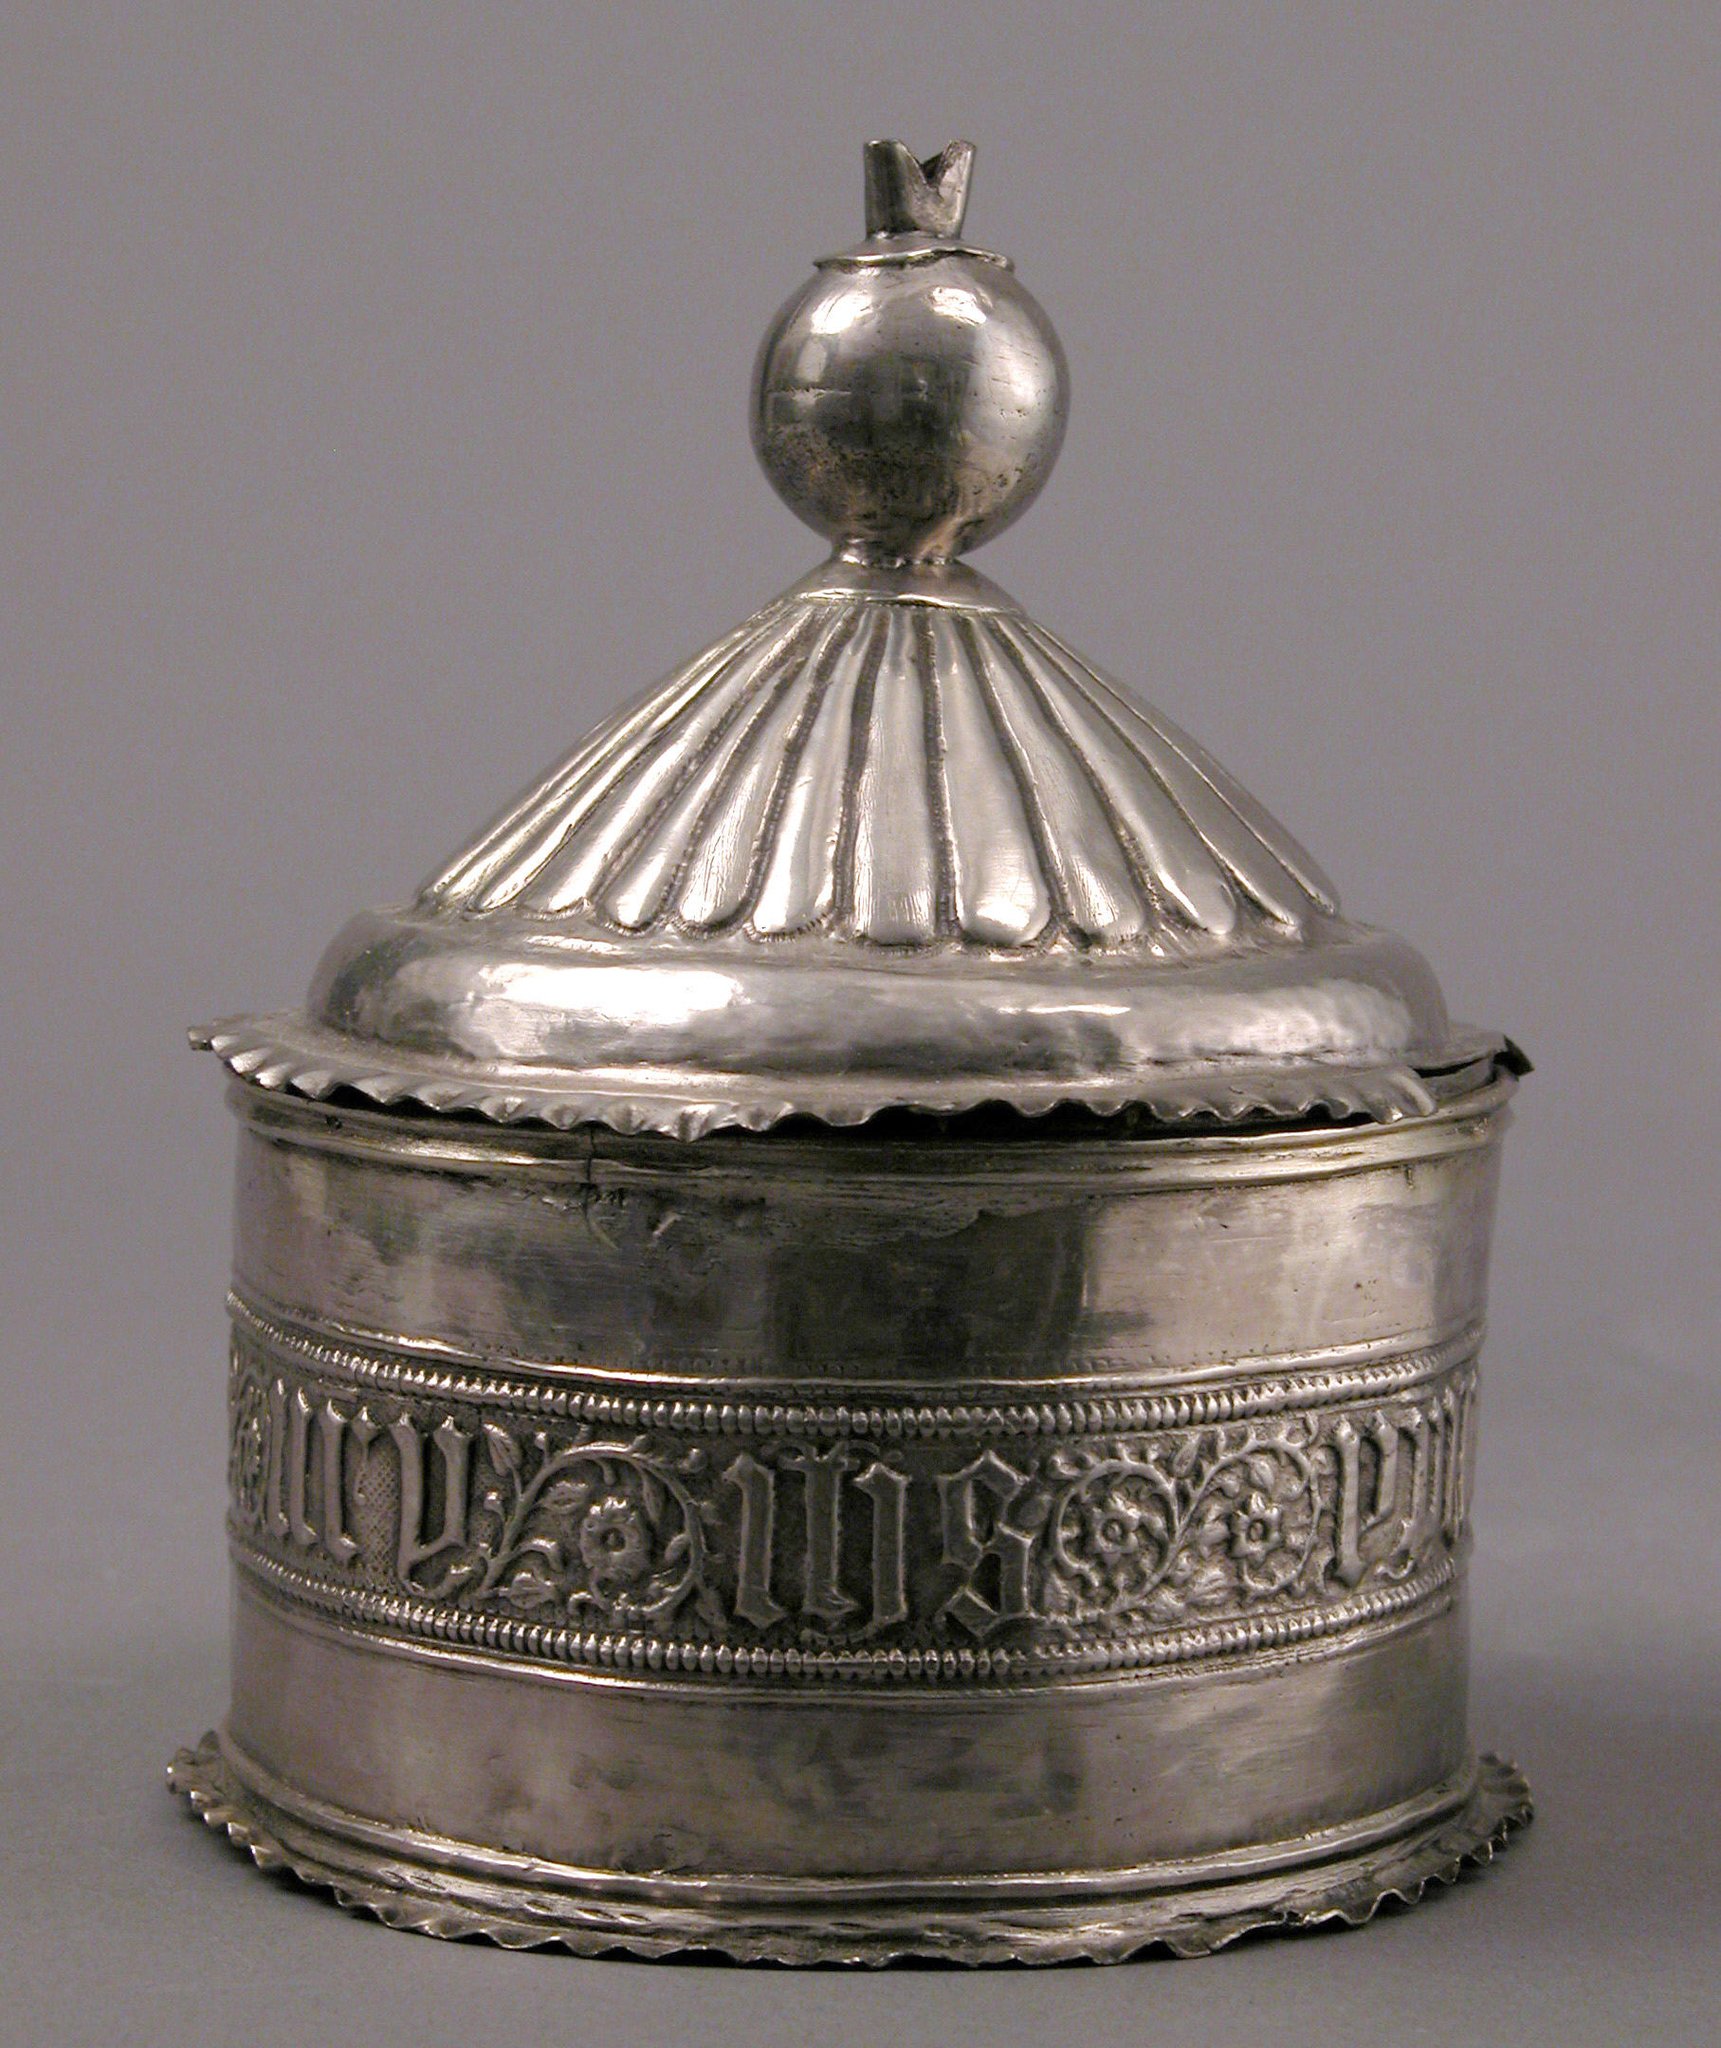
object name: pyx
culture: spanish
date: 1467-1533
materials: silver, silver gilt